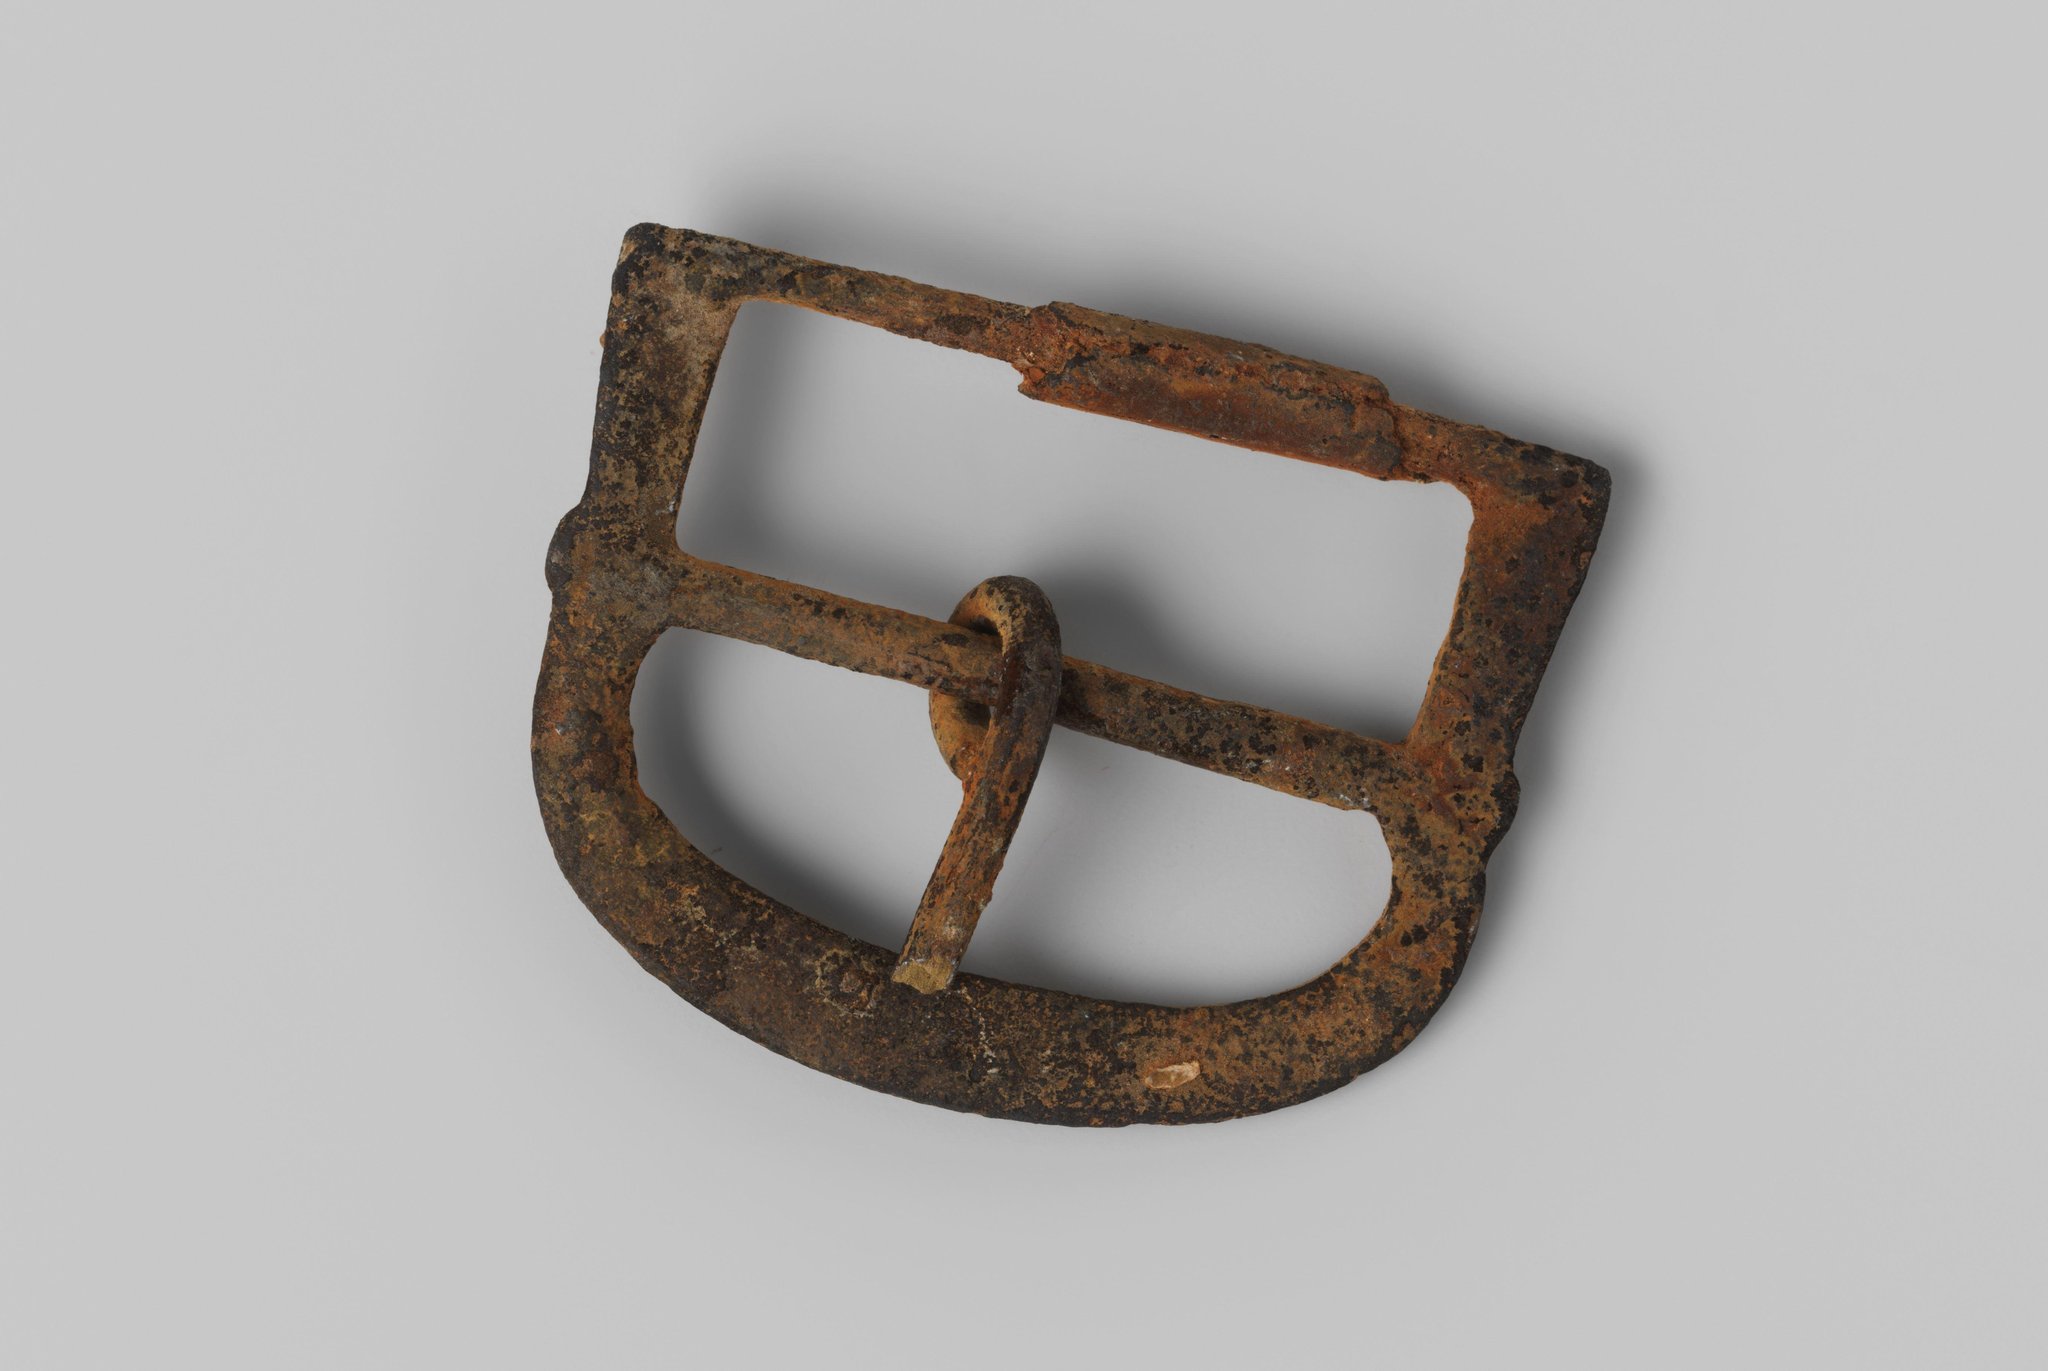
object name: belt buckle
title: Riemgesp uit het wrak van de Oost-Indiëvaarder Hollandia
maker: Anonymous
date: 1700-1743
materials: copper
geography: netherlands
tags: verenigde oostindische compagnie, hollandia (schip), annet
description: D-shaped, id. NG 1979-182H2177, belt buckle.